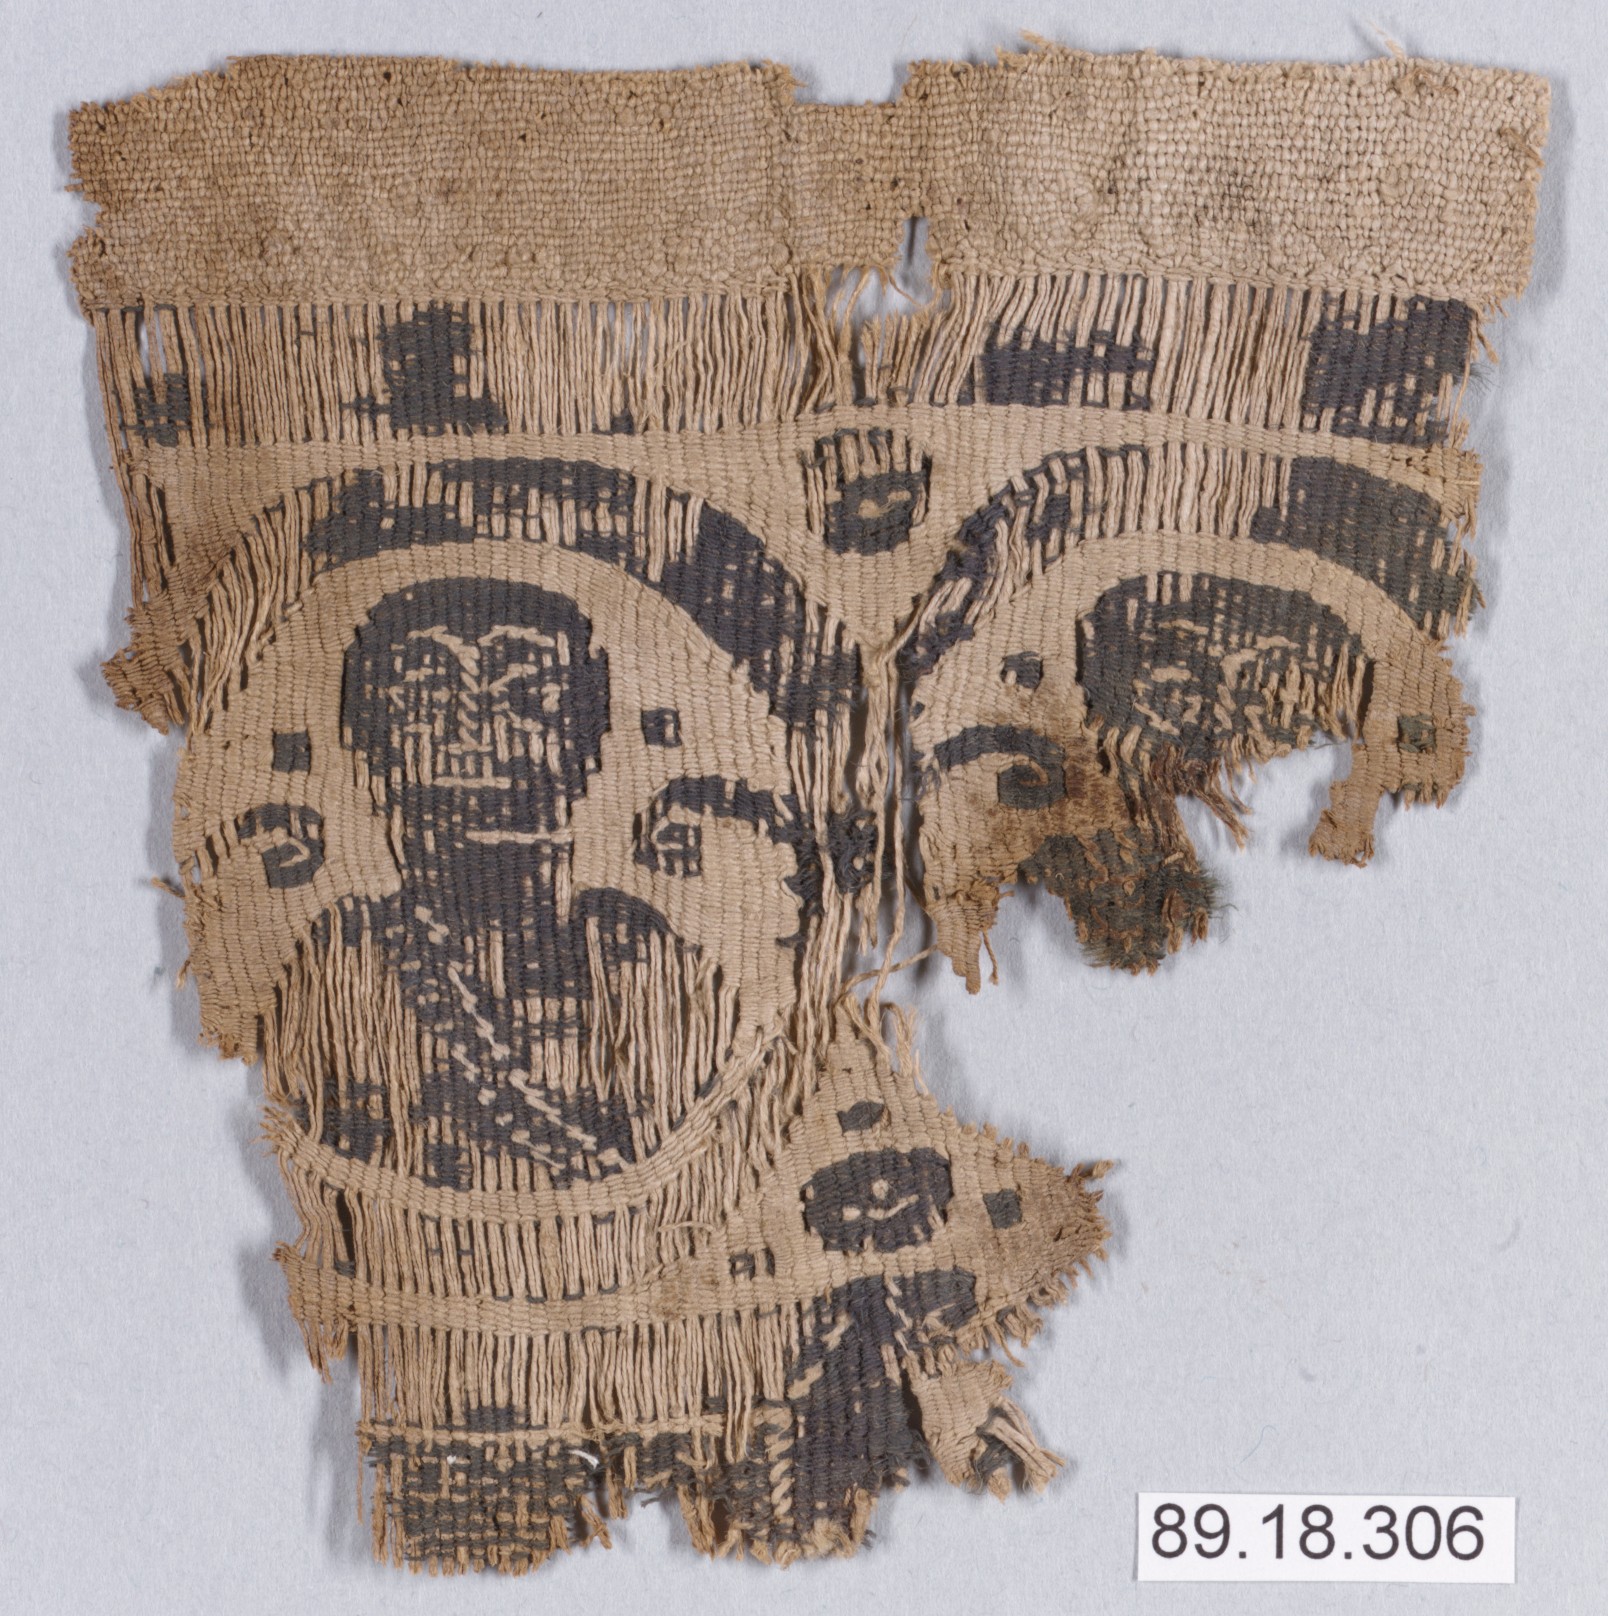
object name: textile fragment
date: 301-400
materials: linen, wool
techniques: weave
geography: egypt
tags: human figures